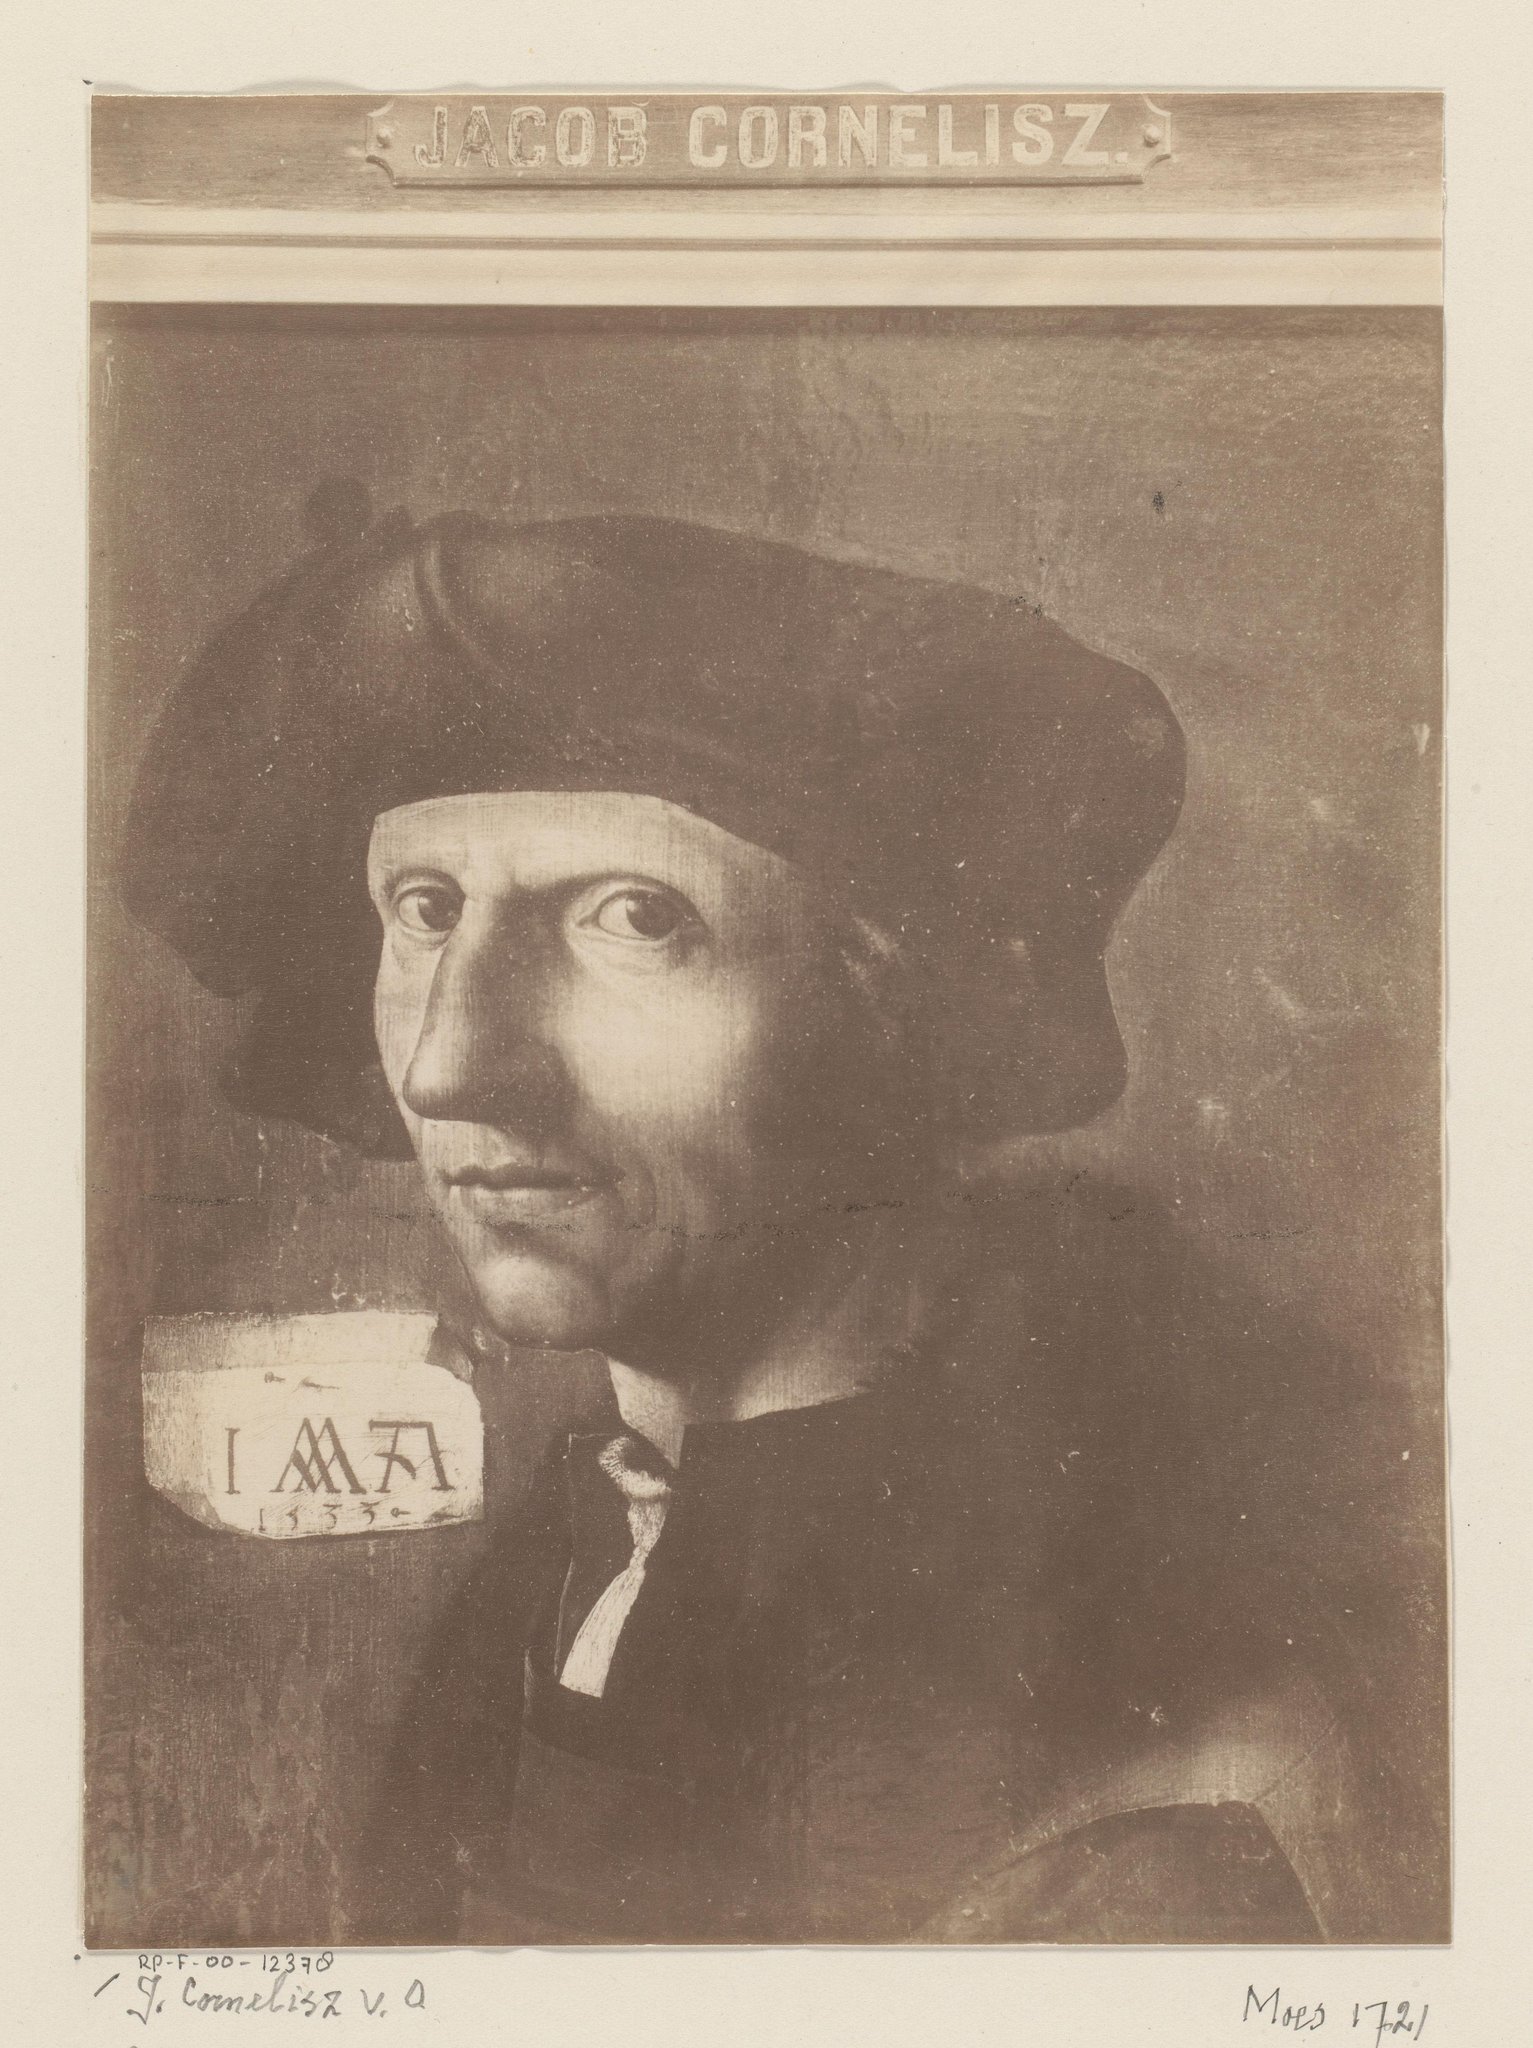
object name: reproduction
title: Fotoreproductie van een geschilderd zelfportret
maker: Anonymous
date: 1851-1900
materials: cardboard, paper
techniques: albumen print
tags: amsterdam, painter, print maker, draughtsman, jacob cornelisz van oostsanen, historical persons, picture, painting